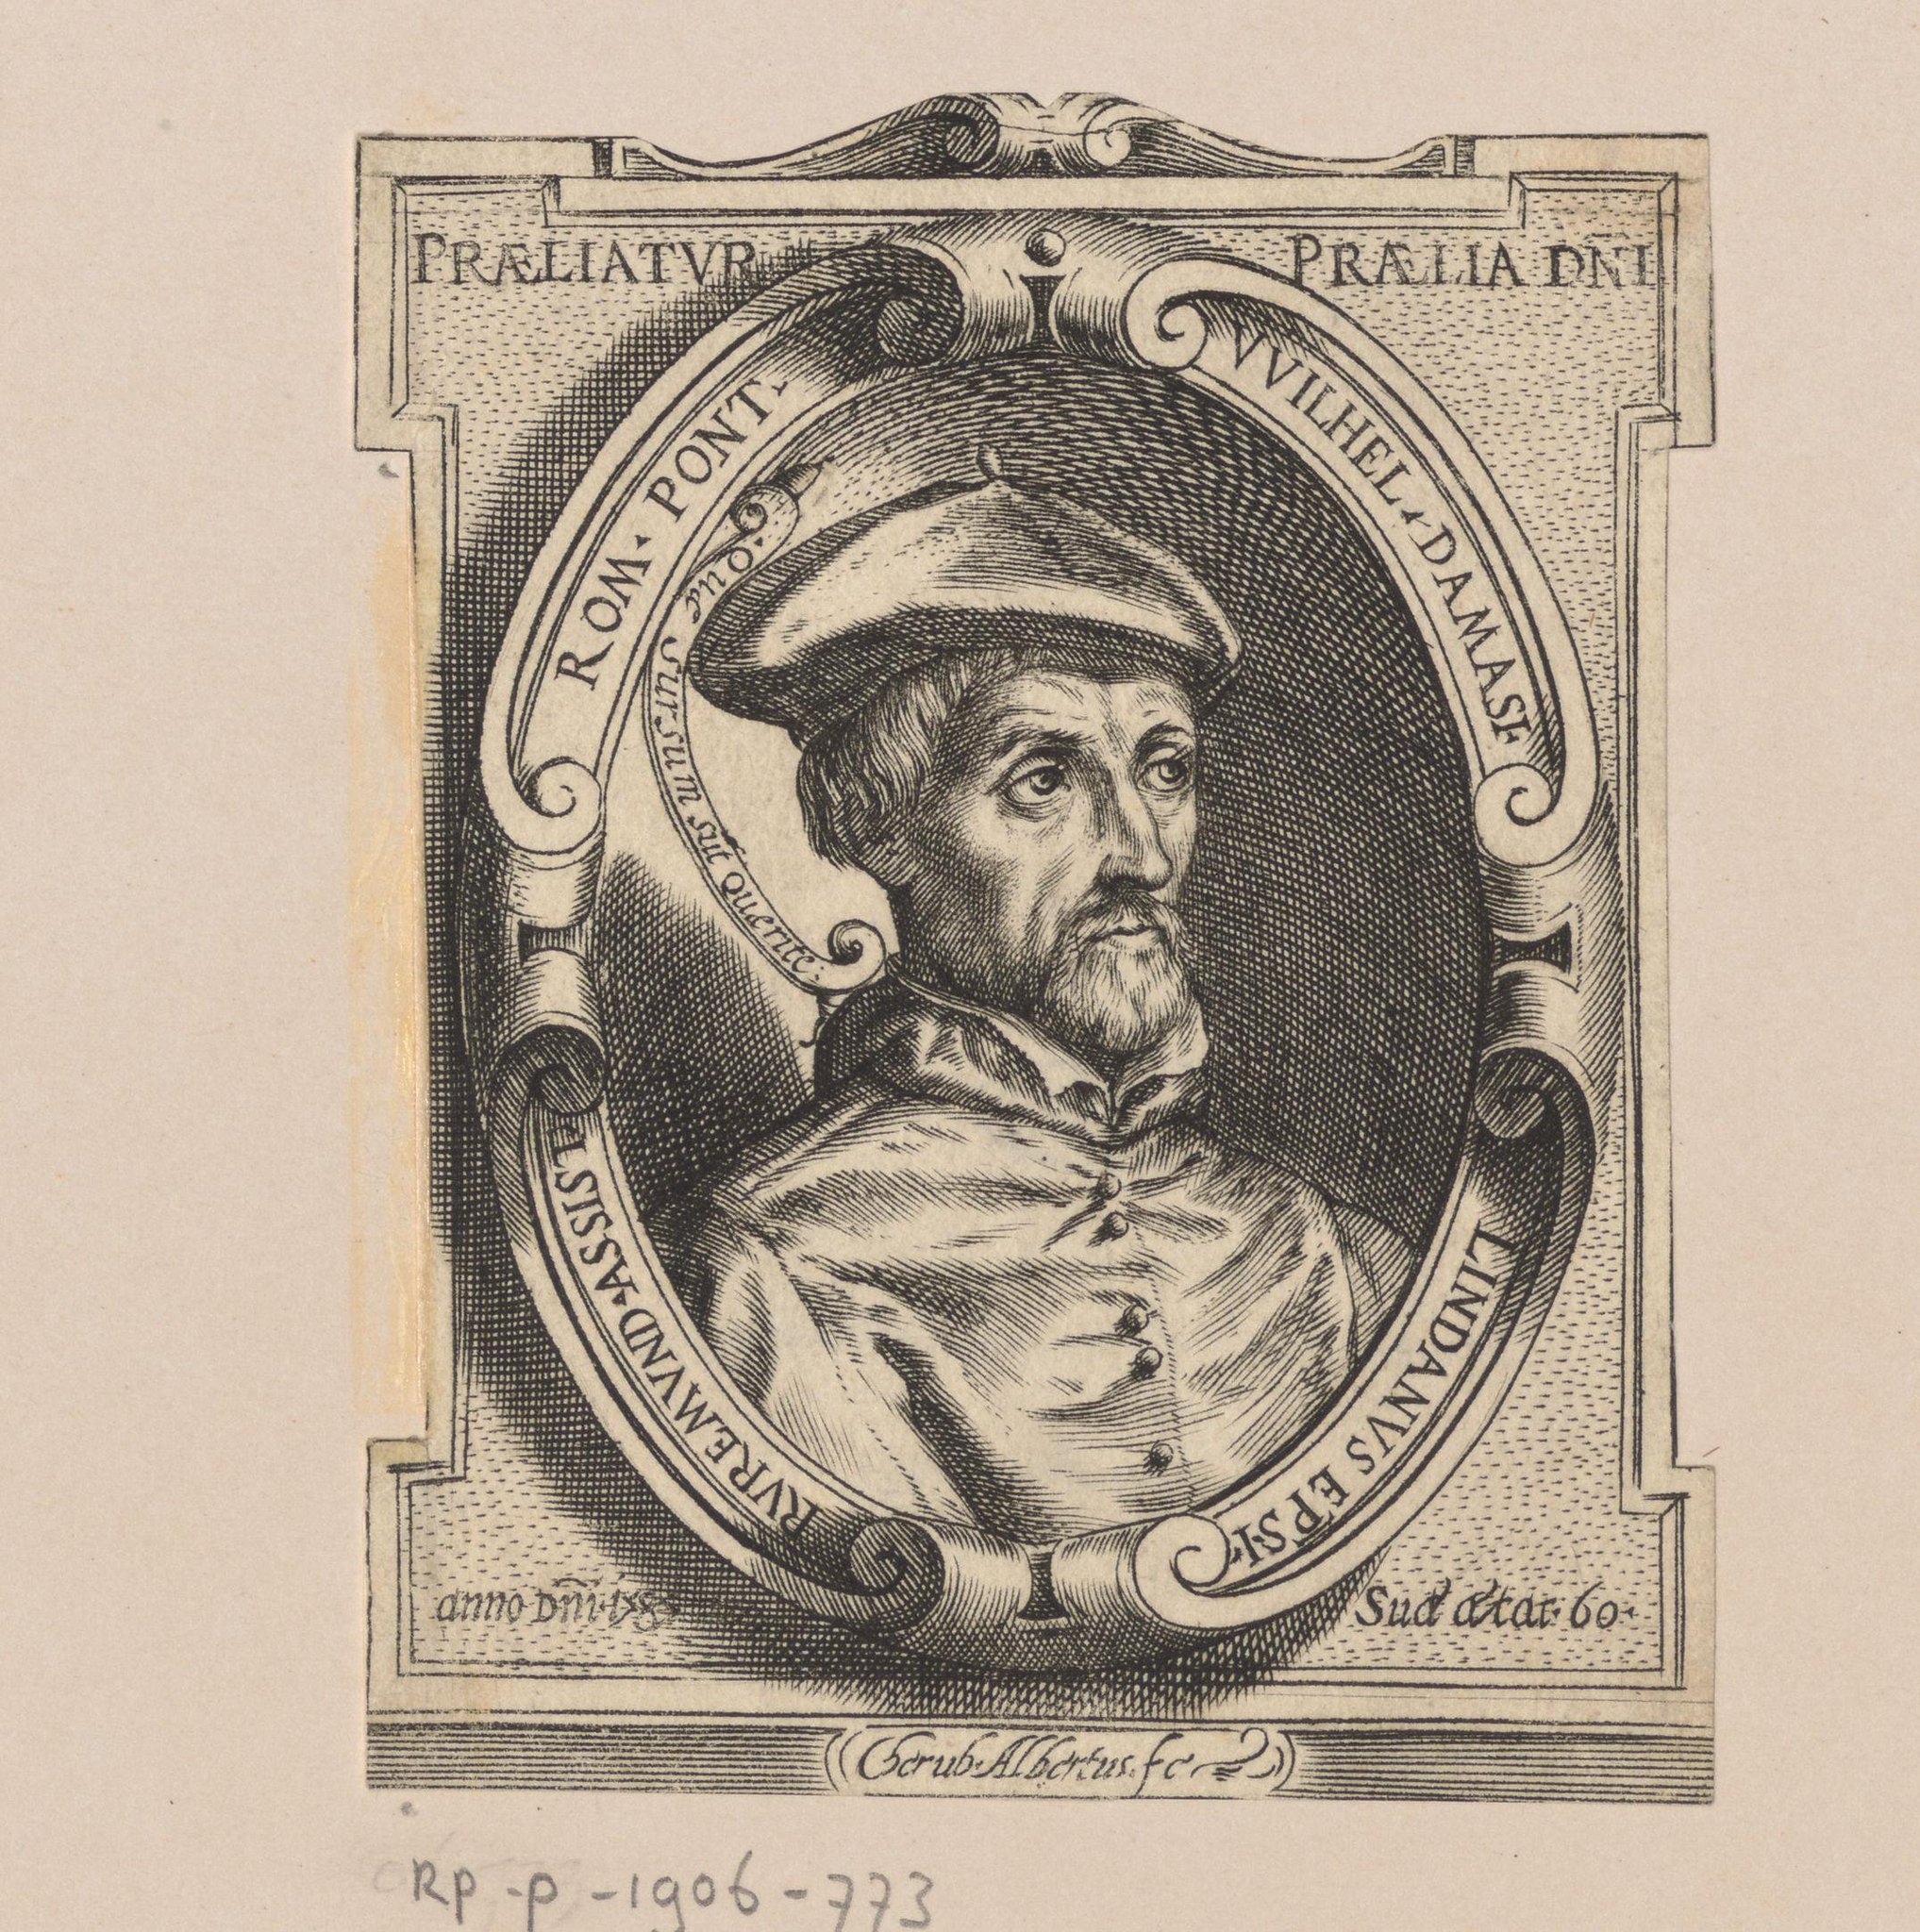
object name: print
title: Portret van Guilielmus Lindanus op 60-jarige leeftijd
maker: cherubino alberti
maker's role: draughtsman, print maker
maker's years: 1553-1615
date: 1585-1587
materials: paper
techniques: engraving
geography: italy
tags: dordrecht, ghent, archbishop, bishop, etc. (roman catholic), historical persons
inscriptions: collector's mark: Lugt 2228